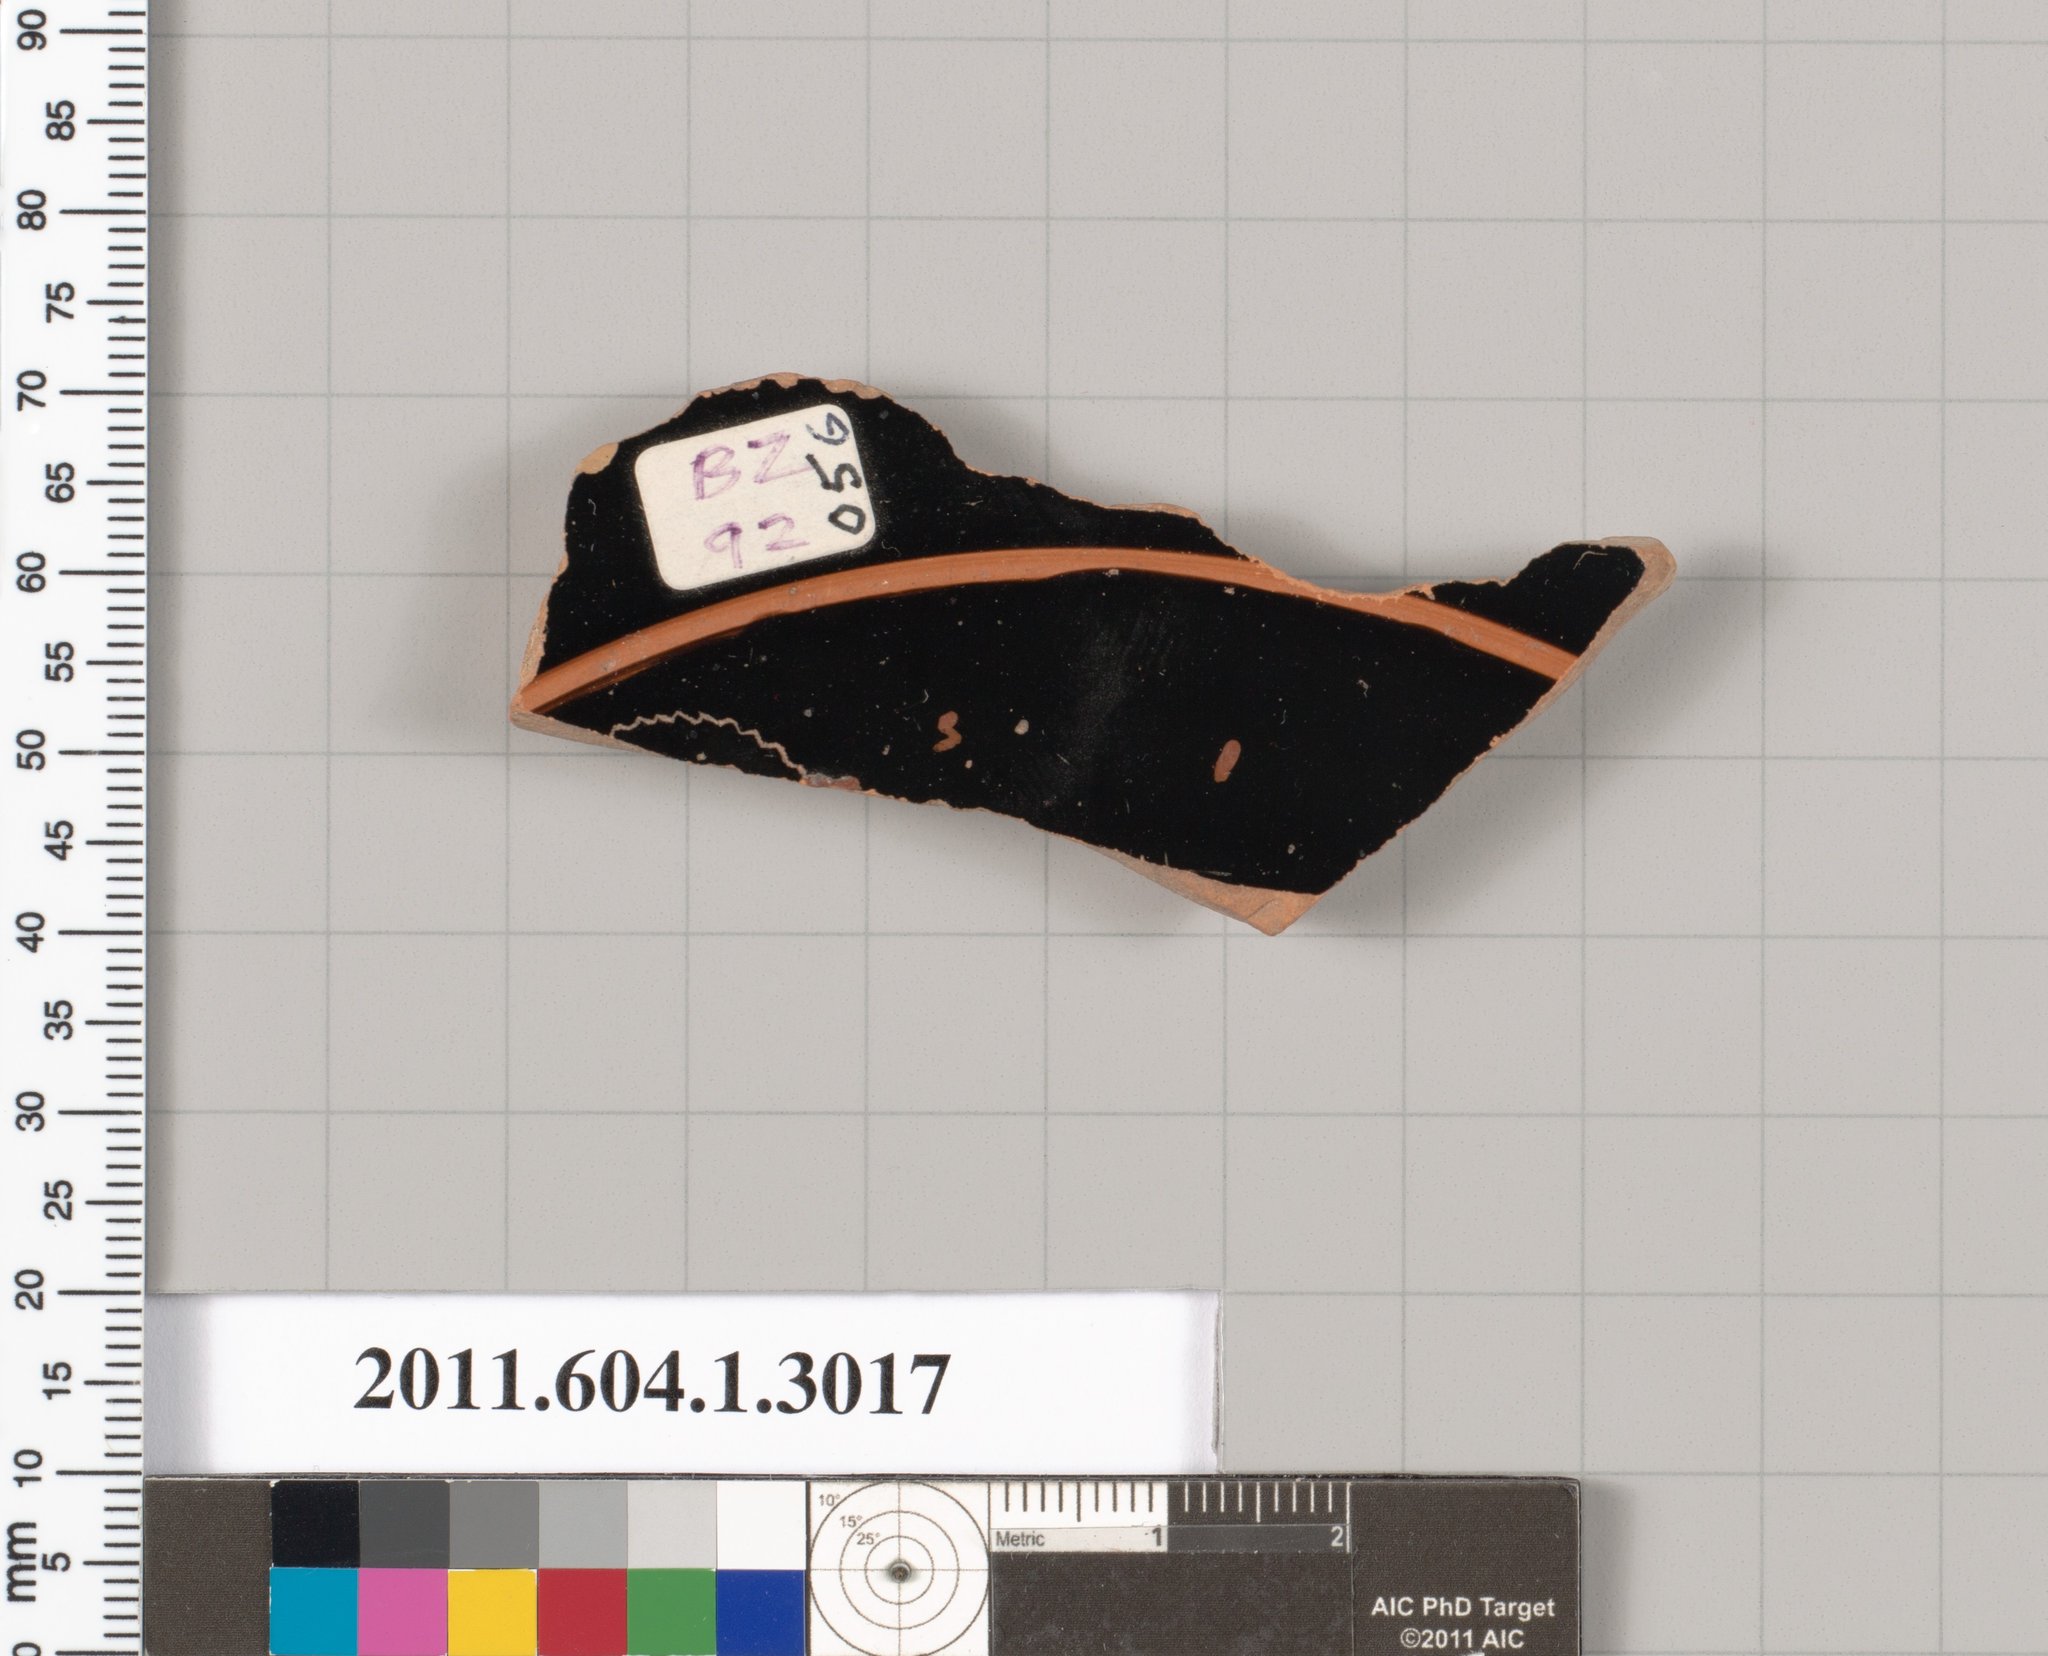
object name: kylix fragment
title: Terracotta fragment of a kylix (drinking cup)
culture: greek, attic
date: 500-490 BCE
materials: terracotta